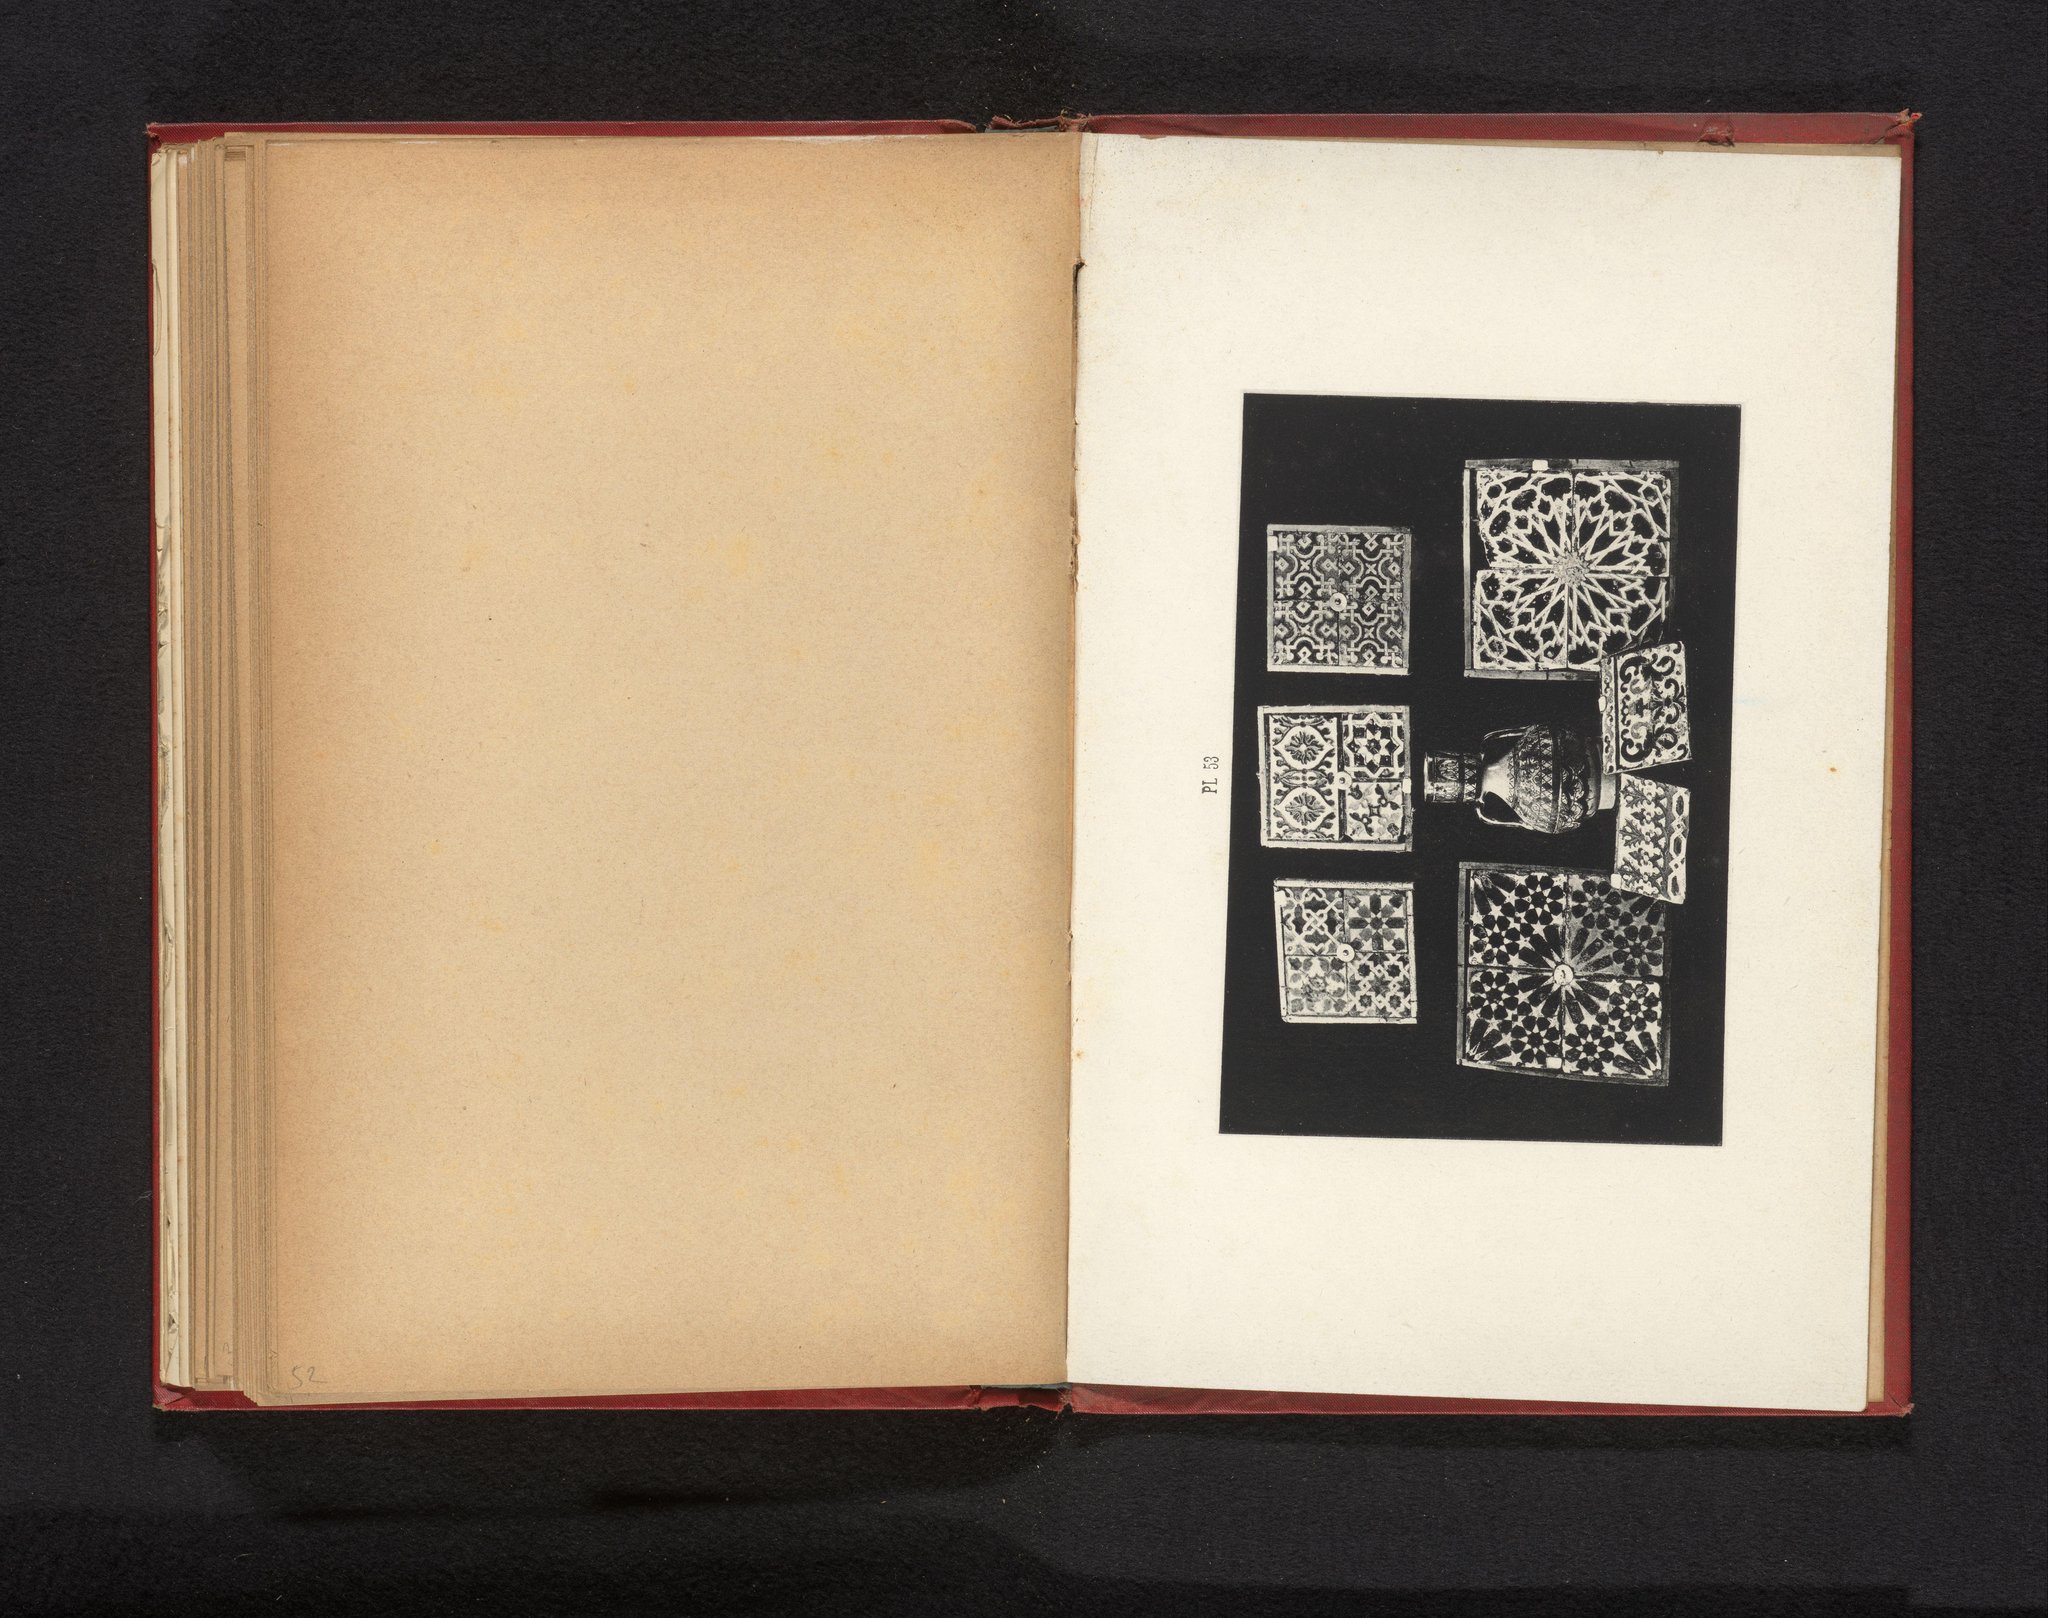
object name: page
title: Opstelling van mozaïektegels en een vaas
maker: Anonymous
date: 1880-1881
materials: paper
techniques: photograph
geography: barcelona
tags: tiles, bricks ~ building material, container of ceramics: jar, jug, pot, vase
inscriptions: number: ‘Pl 53’